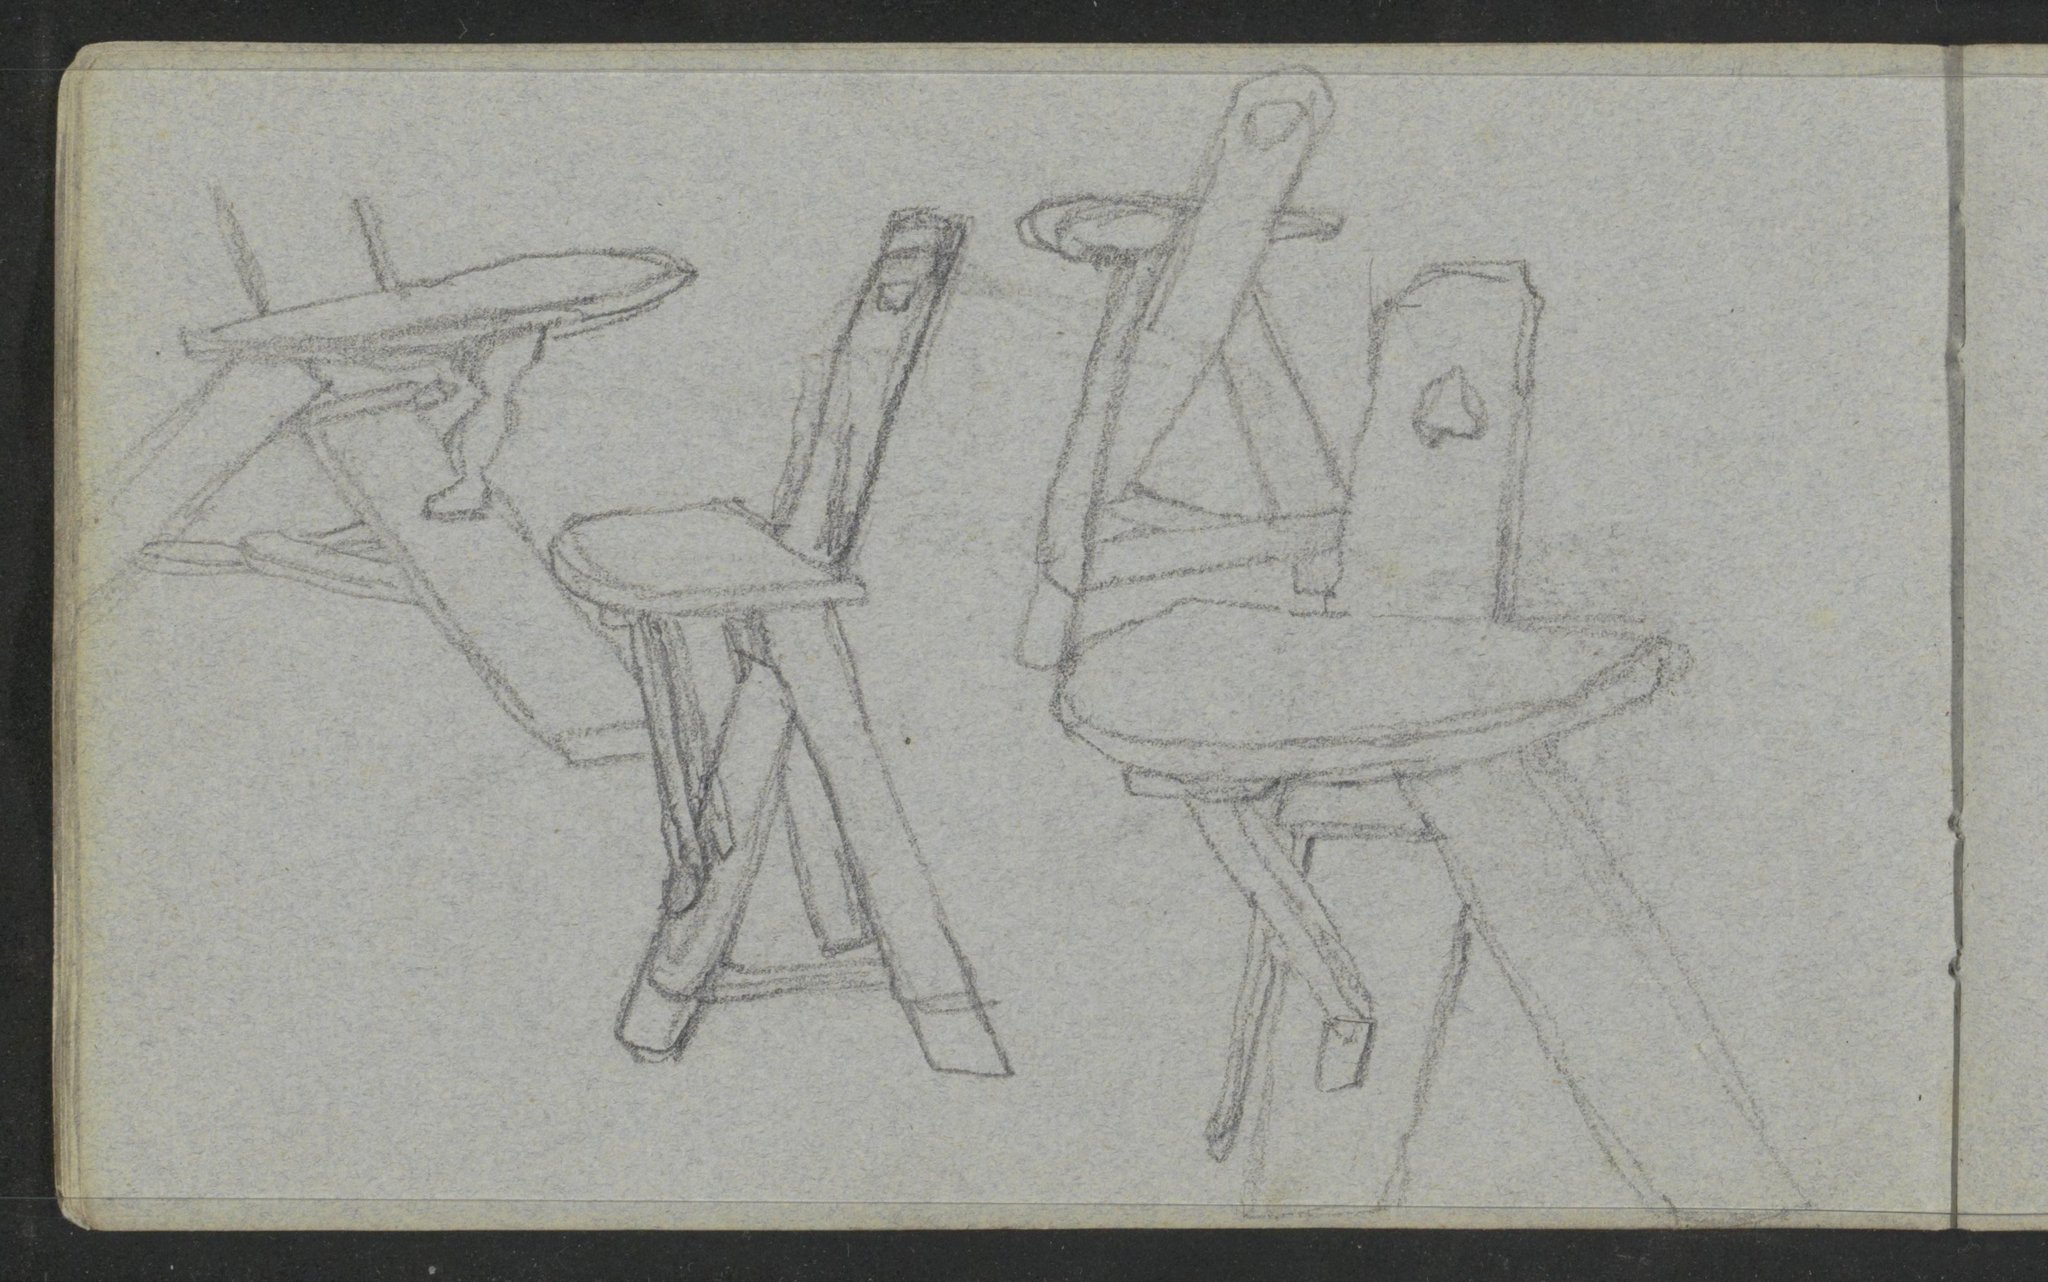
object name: sketchbook leaf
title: Houten krukken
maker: matthijs maris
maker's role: draughtsman, painter, print maker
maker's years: 1839-1917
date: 1849-1917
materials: paper, pencil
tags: stool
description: Blad 4 verso uit een schetsboek met 35 bladen.